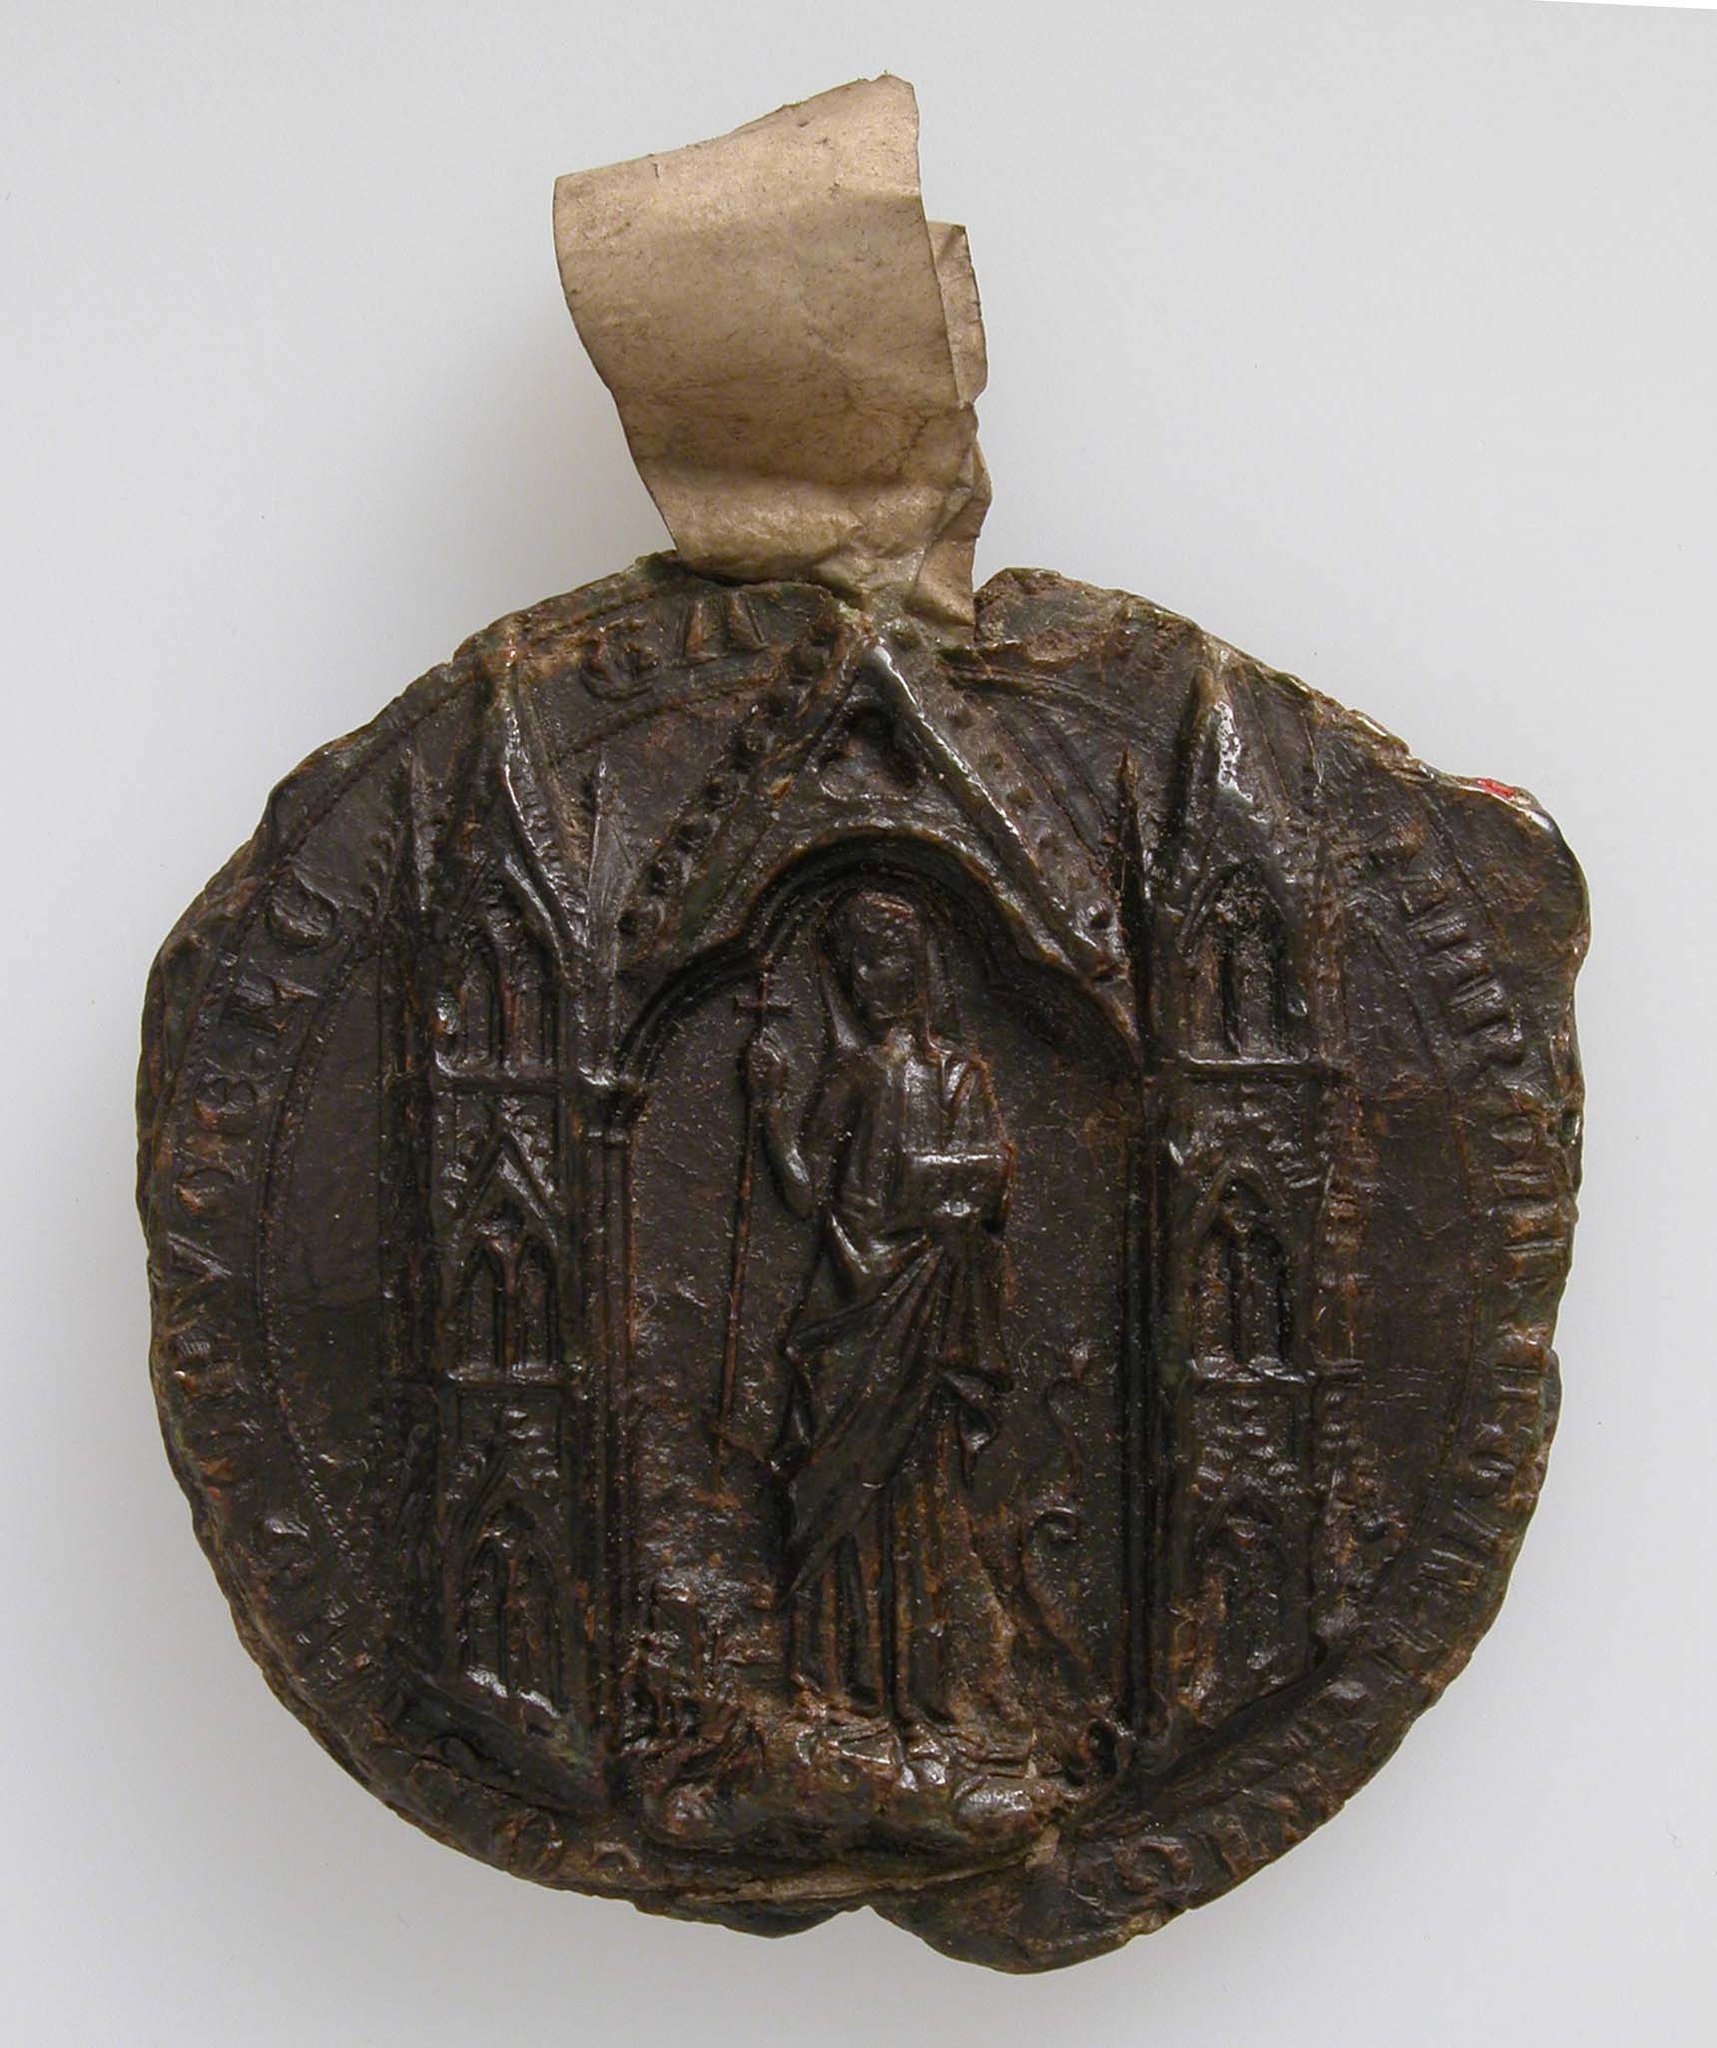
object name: seal impression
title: Seal Impression, Saint Margaret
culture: dutch or south lowlands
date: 1358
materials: wax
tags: women,saints